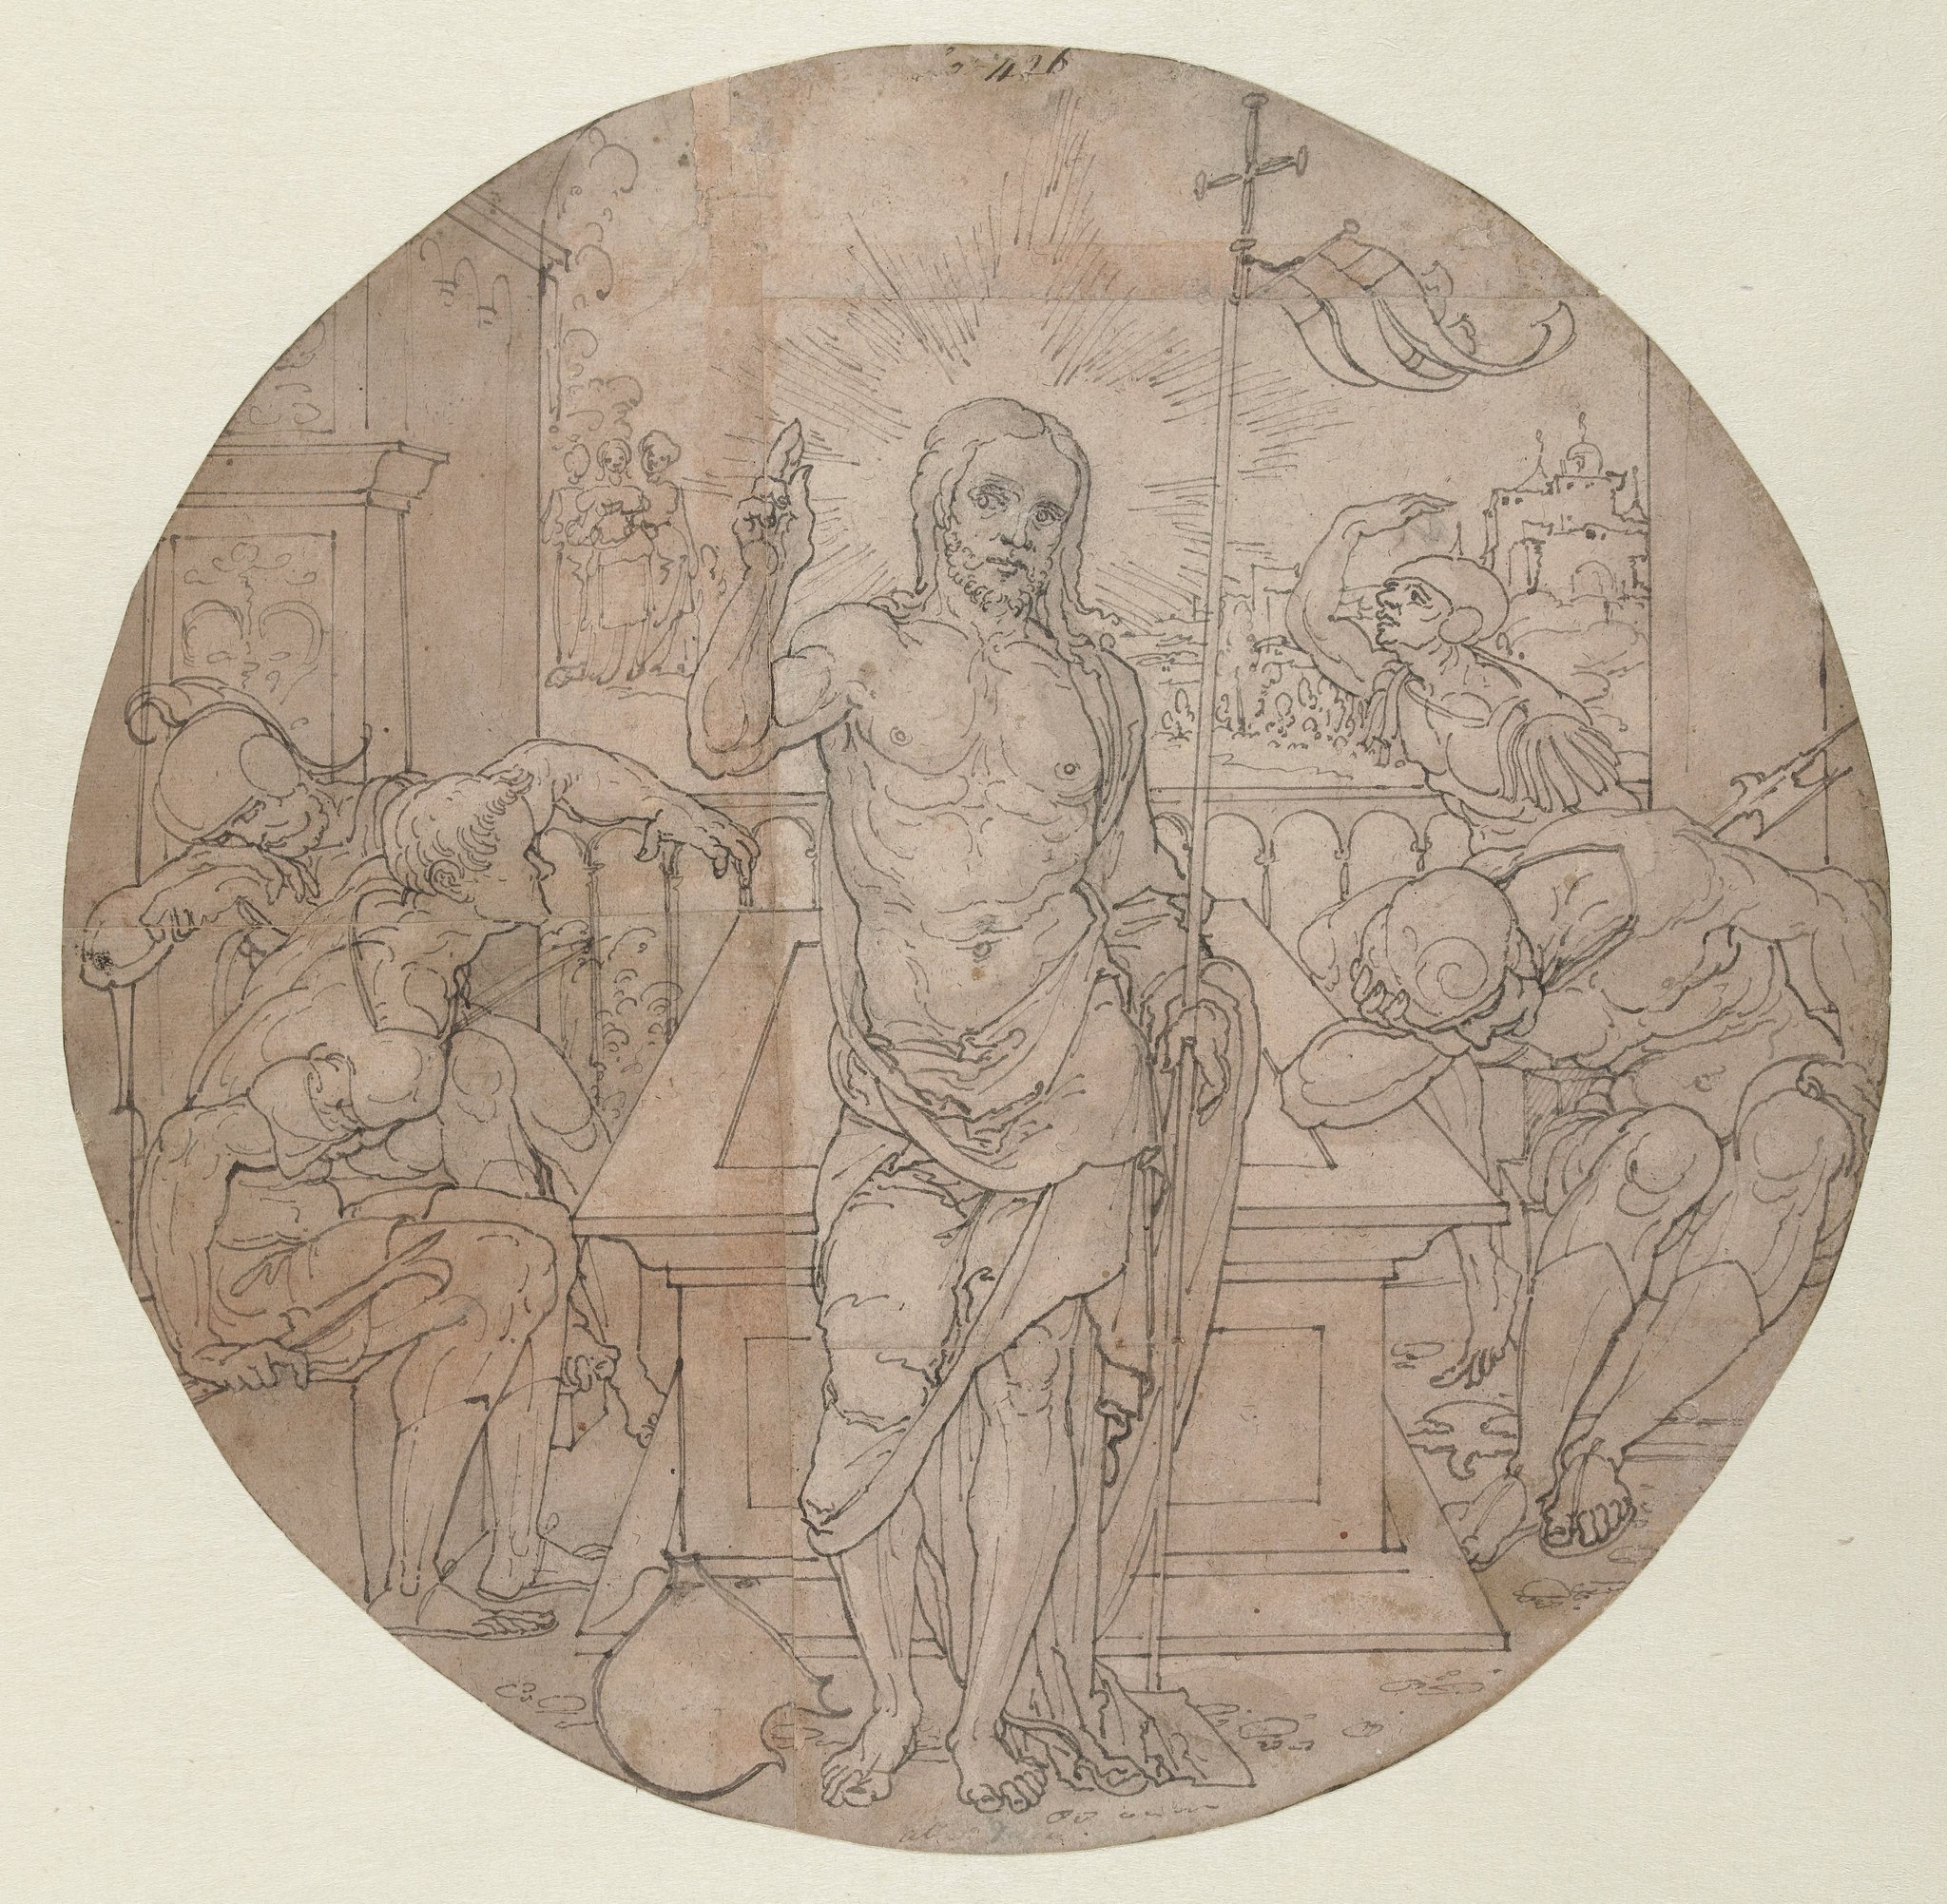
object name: drawing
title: De Opstanding van Christus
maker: nicolaas hogenberg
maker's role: draughtsman, painter, print maker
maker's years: 1500-1539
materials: ink, paper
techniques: brush, pen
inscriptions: inscription: ‘bovenaan genummerd: ..426; onderaan een onleesbaar geworden opschrift’